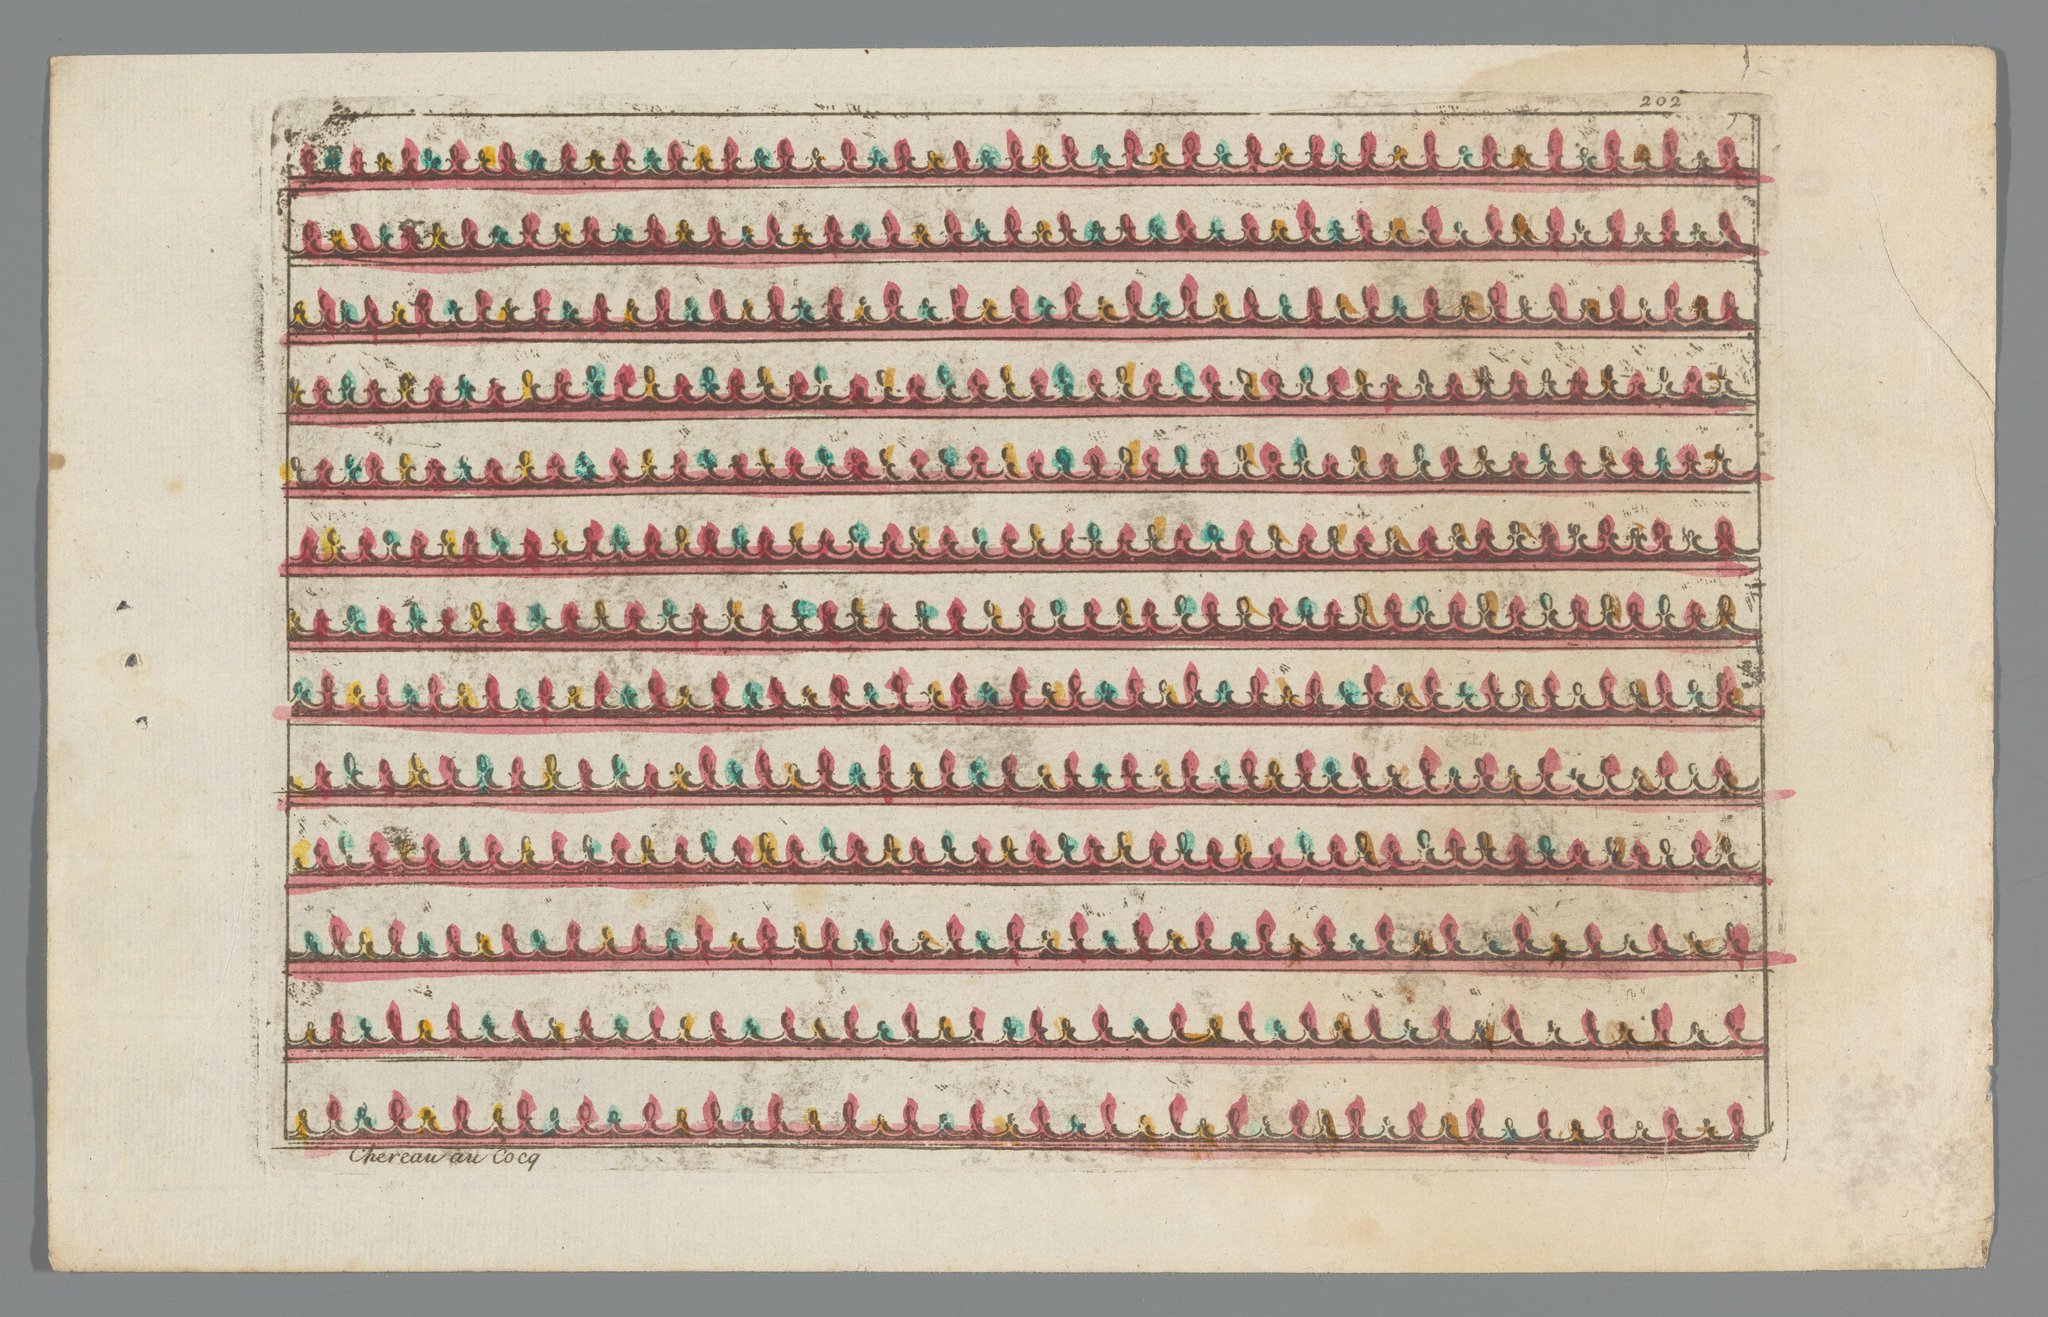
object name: print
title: Bladen met knipplaatjes en decoratieve randen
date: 1750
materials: paper, watercolor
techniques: etching, hand coloring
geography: paris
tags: ornament ~ geometric motifs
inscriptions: collector's mark: Lugt 2760, collector's mark: Lugt 2228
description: Blad met dertien identieke sierlijsten. Rechtsboven genummerd: 202. Een van 39 bladen met knipplaatjes en decoratieve randen.